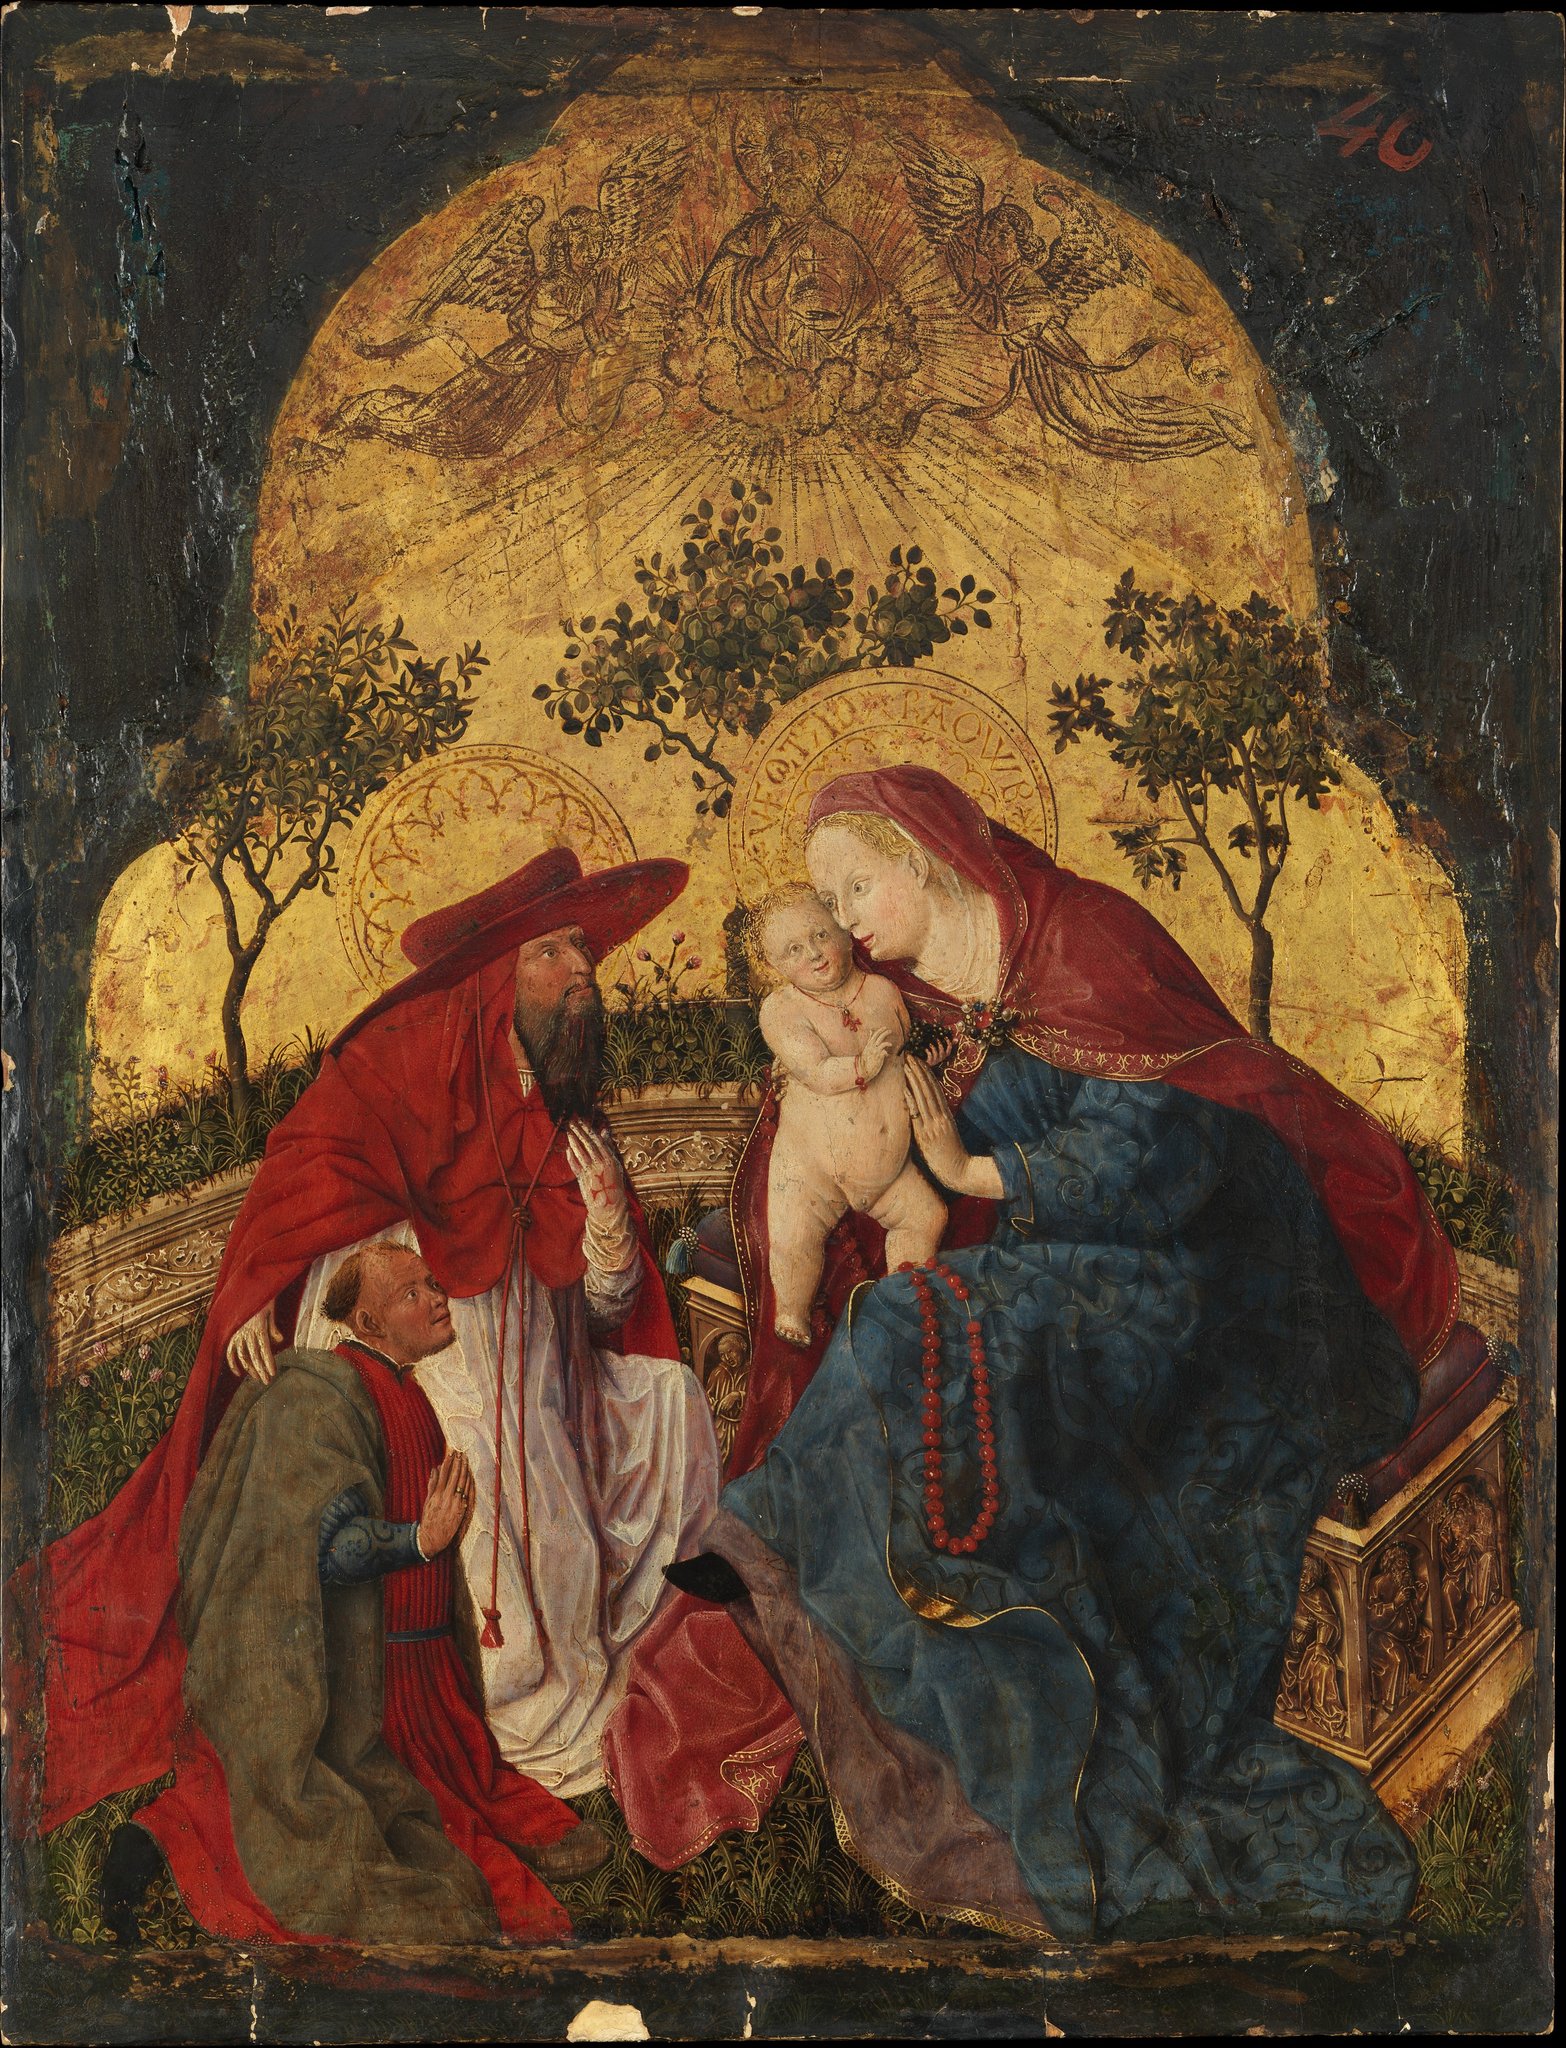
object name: painting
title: Virgin and Child with a Donor Presented by Saint Jerome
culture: bavarian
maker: master of the munich bavarian panels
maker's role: artist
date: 1450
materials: gold, oil, panel, wood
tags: men,madonna and child,saint jerome